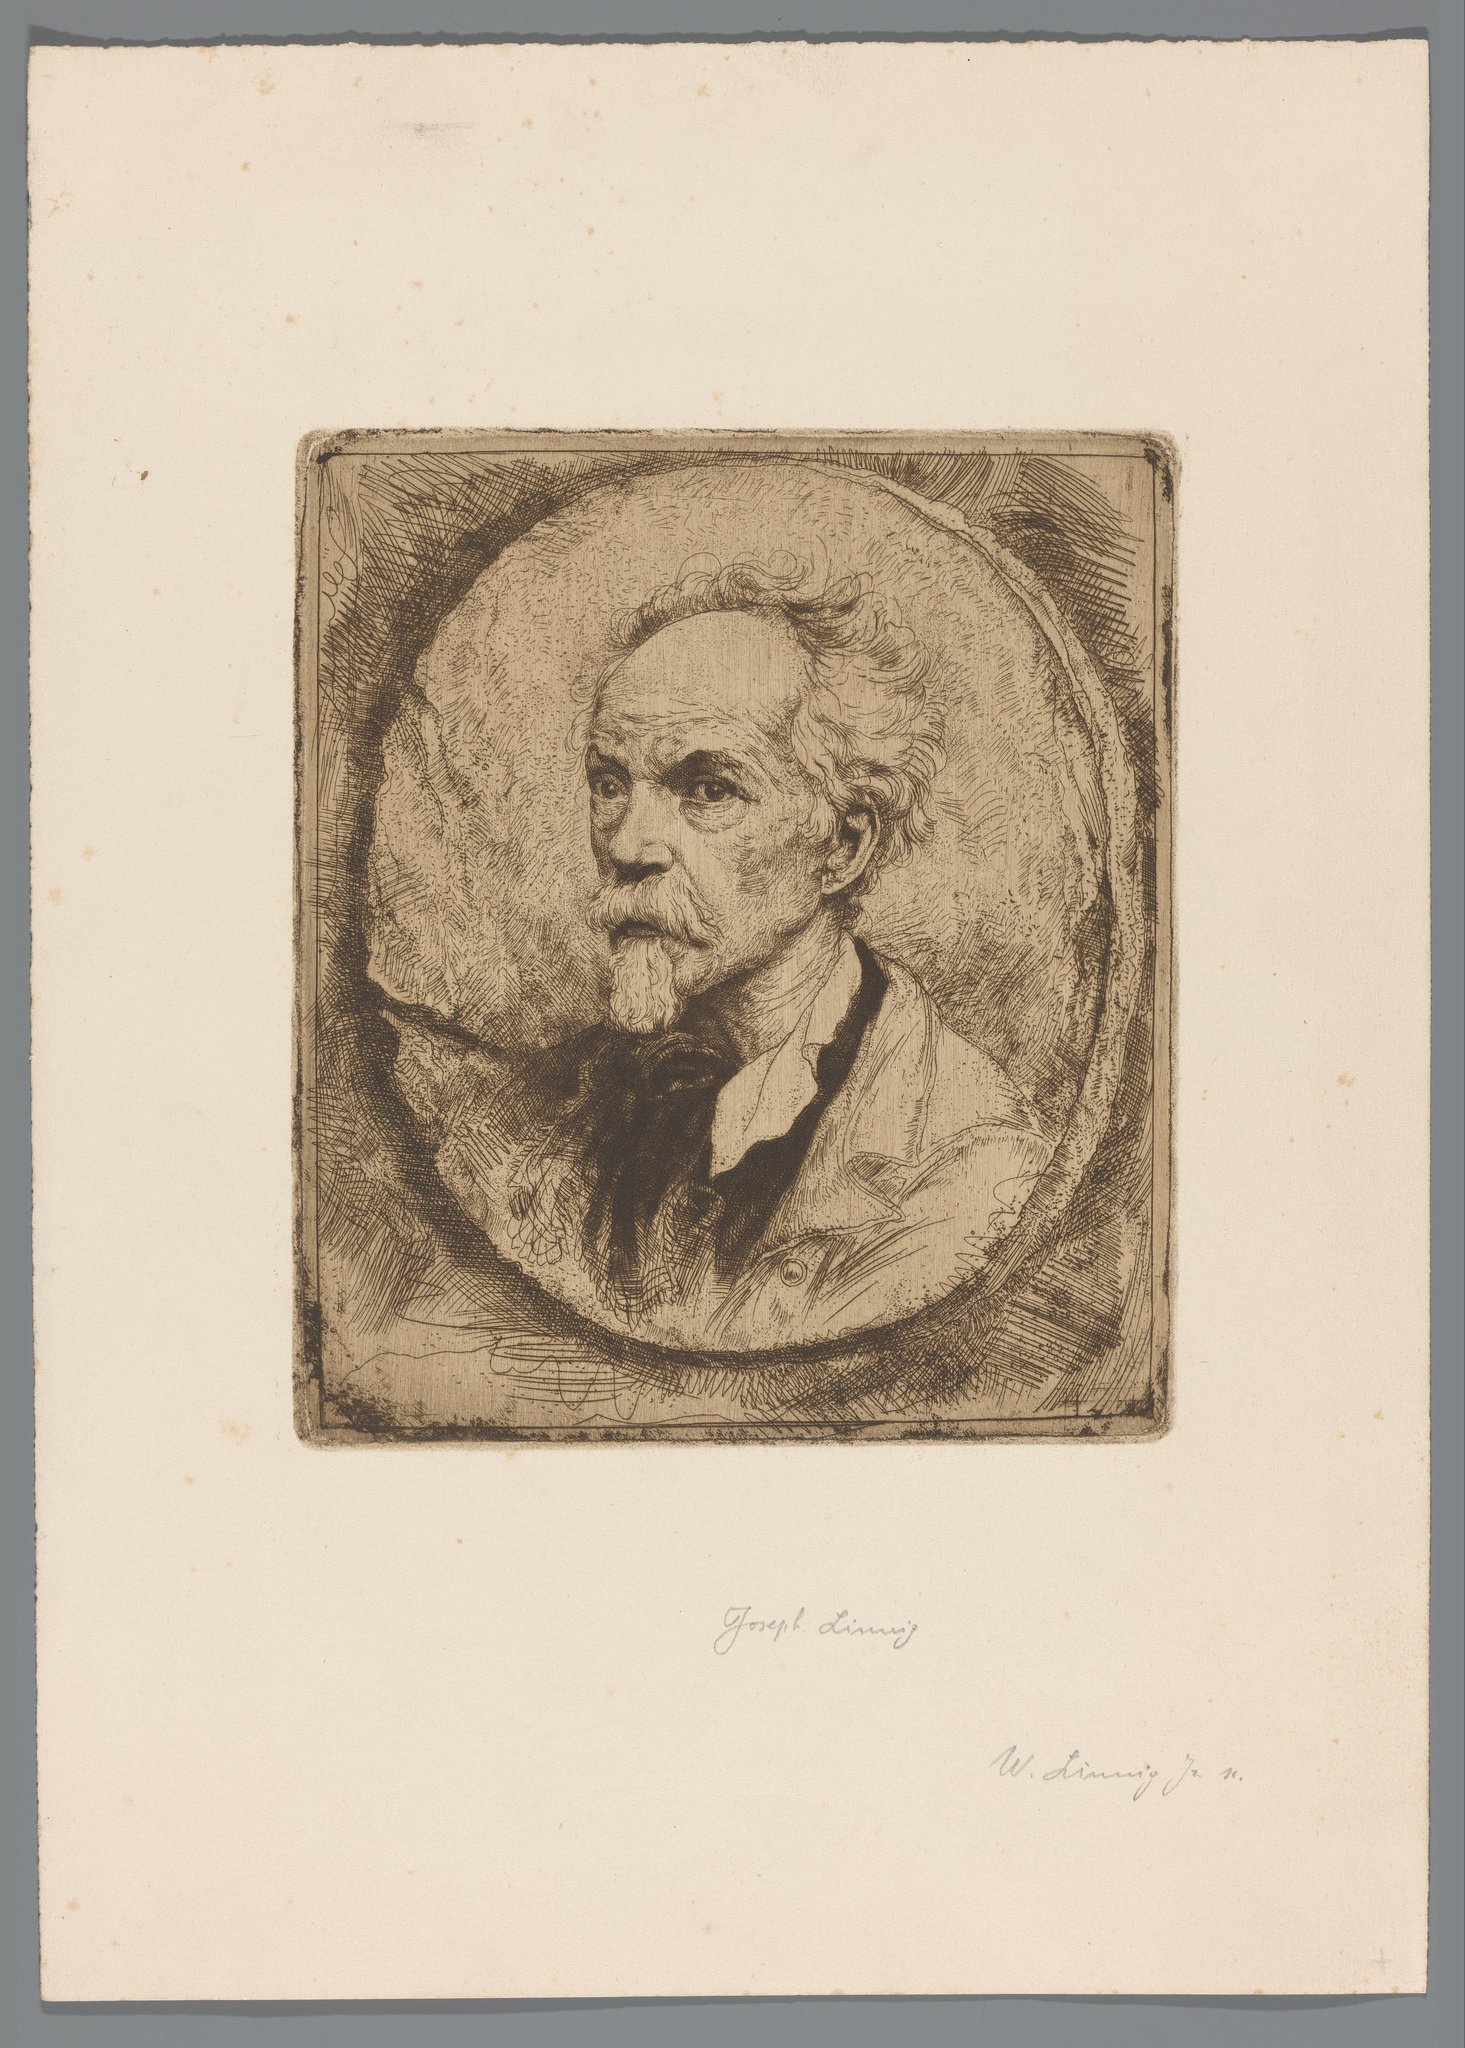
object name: print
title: Portret van Jean Théodore Joseph Linnig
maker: willem linnig (ii)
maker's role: print maker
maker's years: 1842-1890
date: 1852-1890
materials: paper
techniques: drypoint, etching, intaglio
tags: antwerp, print maker, draughtsman, jean théodore joseph linnig, historical persons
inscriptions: collector's mark: Lugt 2228